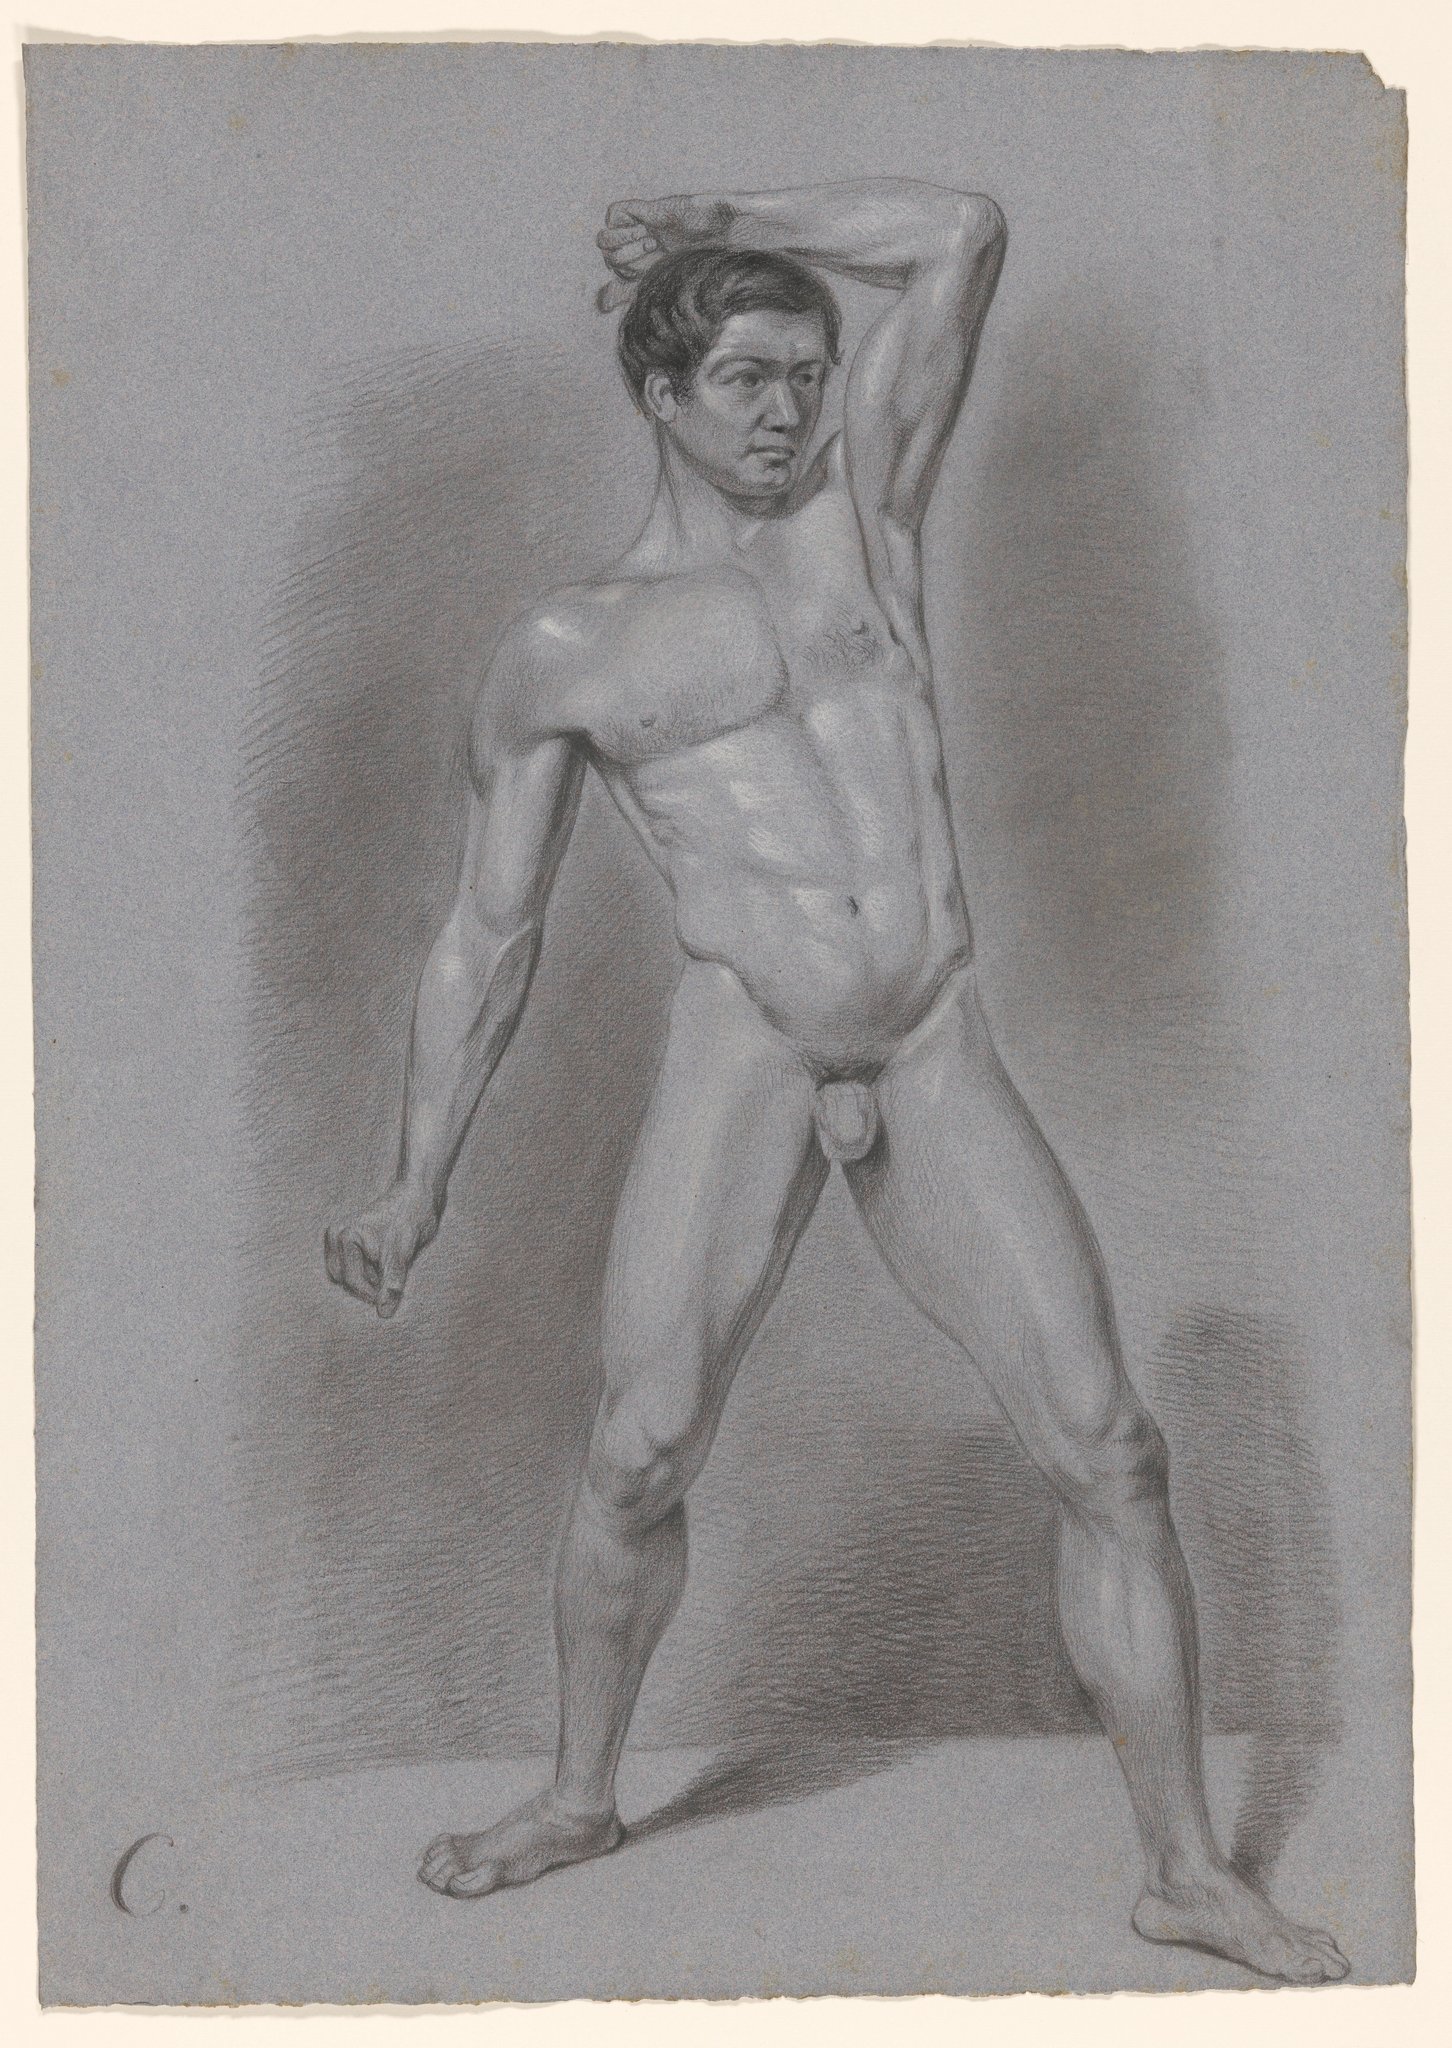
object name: drawing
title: Staand mannelijk naakt, van voren gezien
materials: chalk, paper